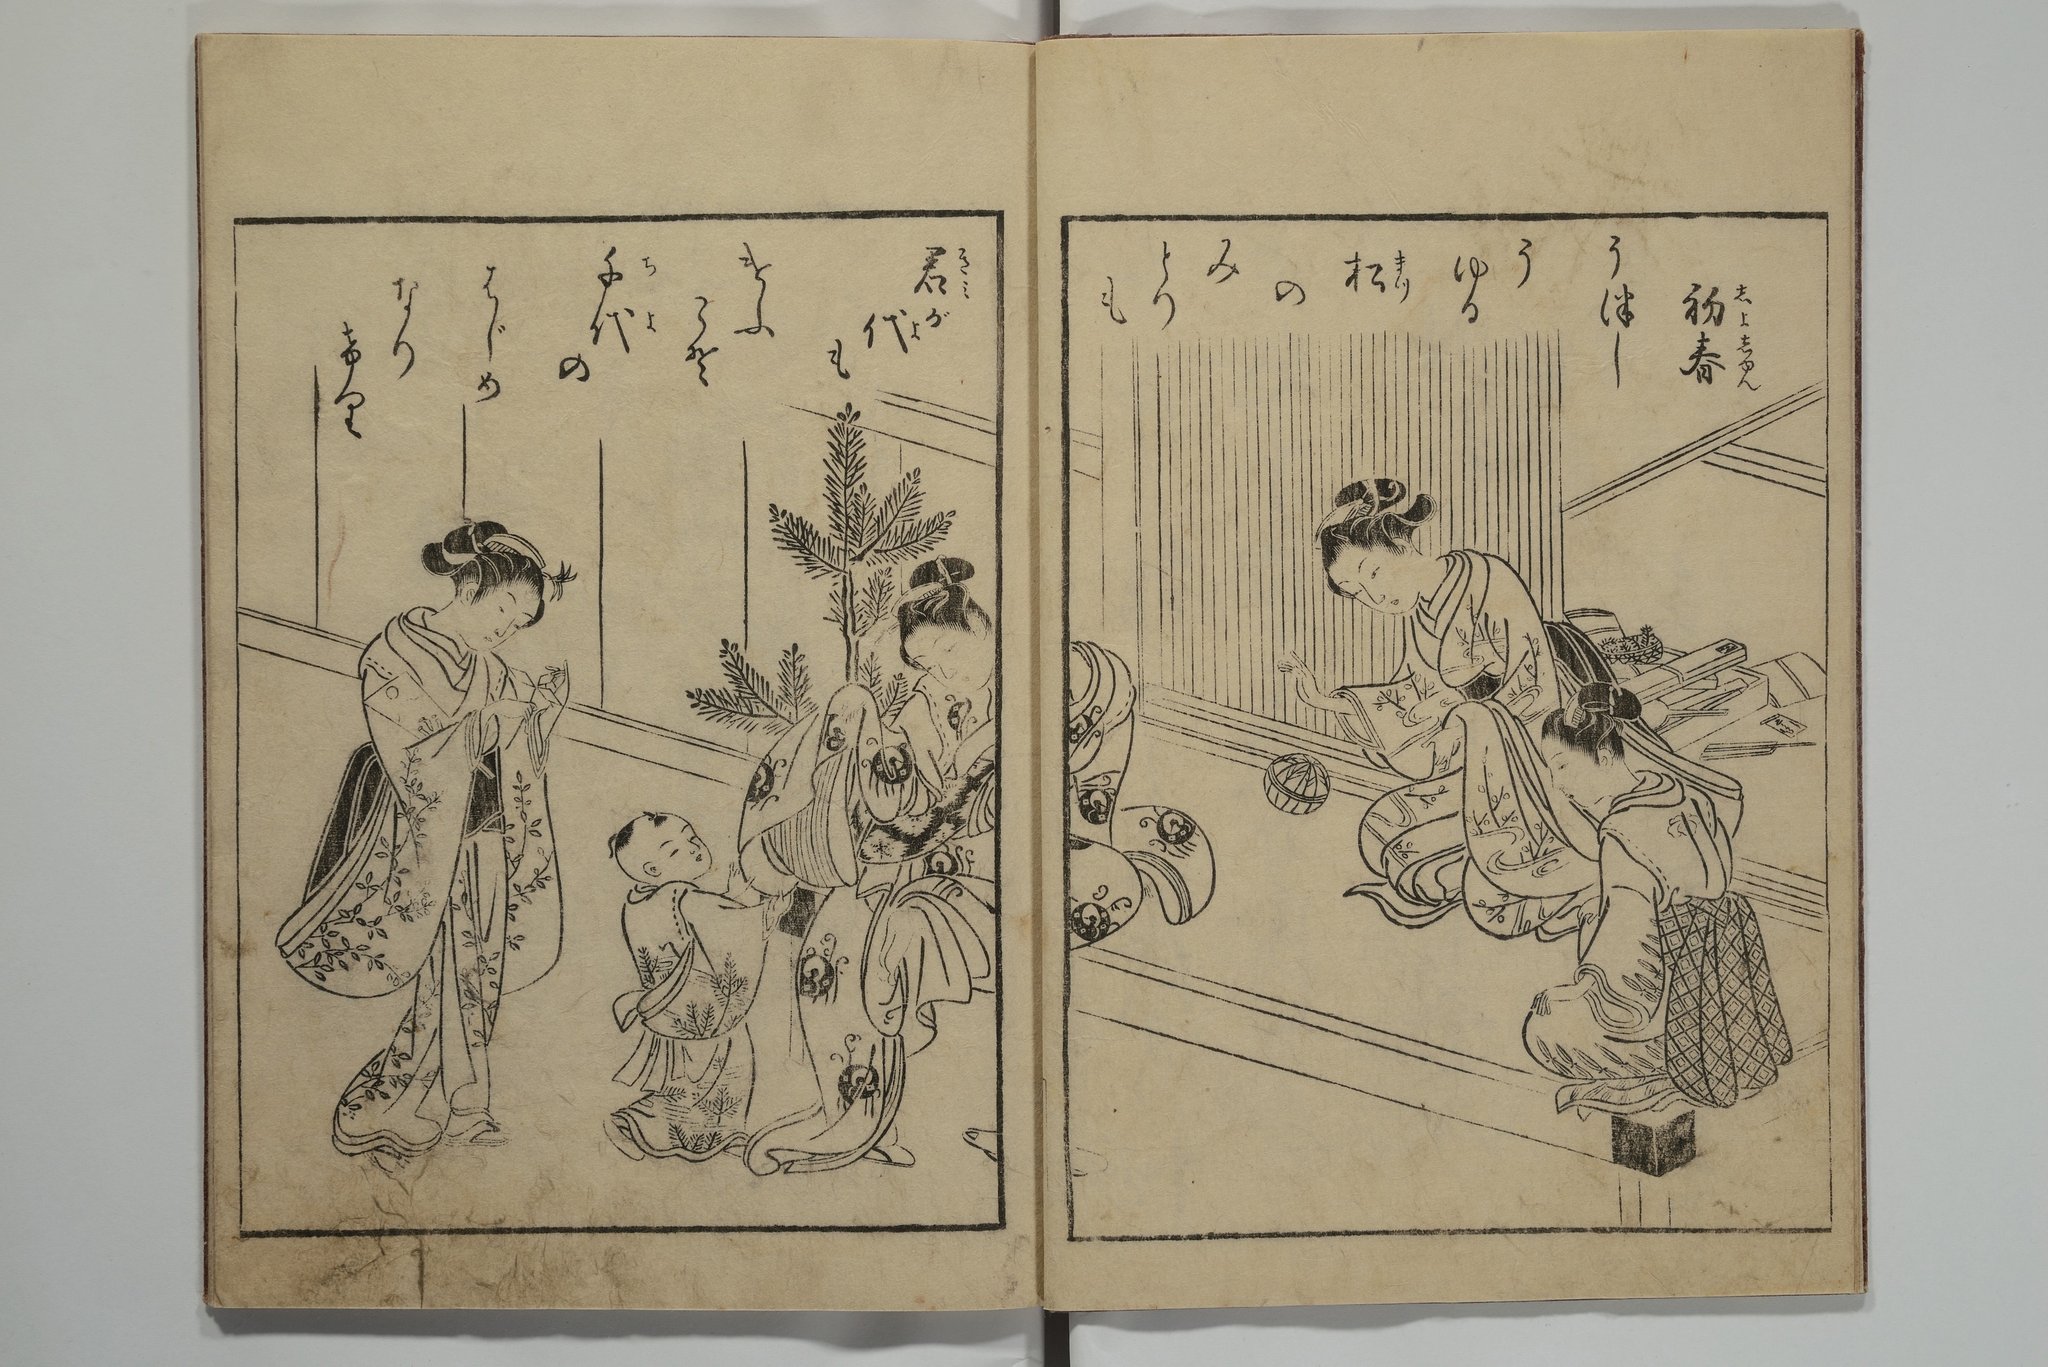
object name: illustrated book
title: Picture Book of the Eternal Pines (Ehon chiyo no matsu) 絵本千代の松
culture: japanese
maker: suzuki harunobu 鈴木春信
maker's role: artist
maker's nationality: japanese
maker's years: 1725-1770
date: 1767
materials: ink, paper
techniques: woodblock print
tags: children,women,horses,landscapes